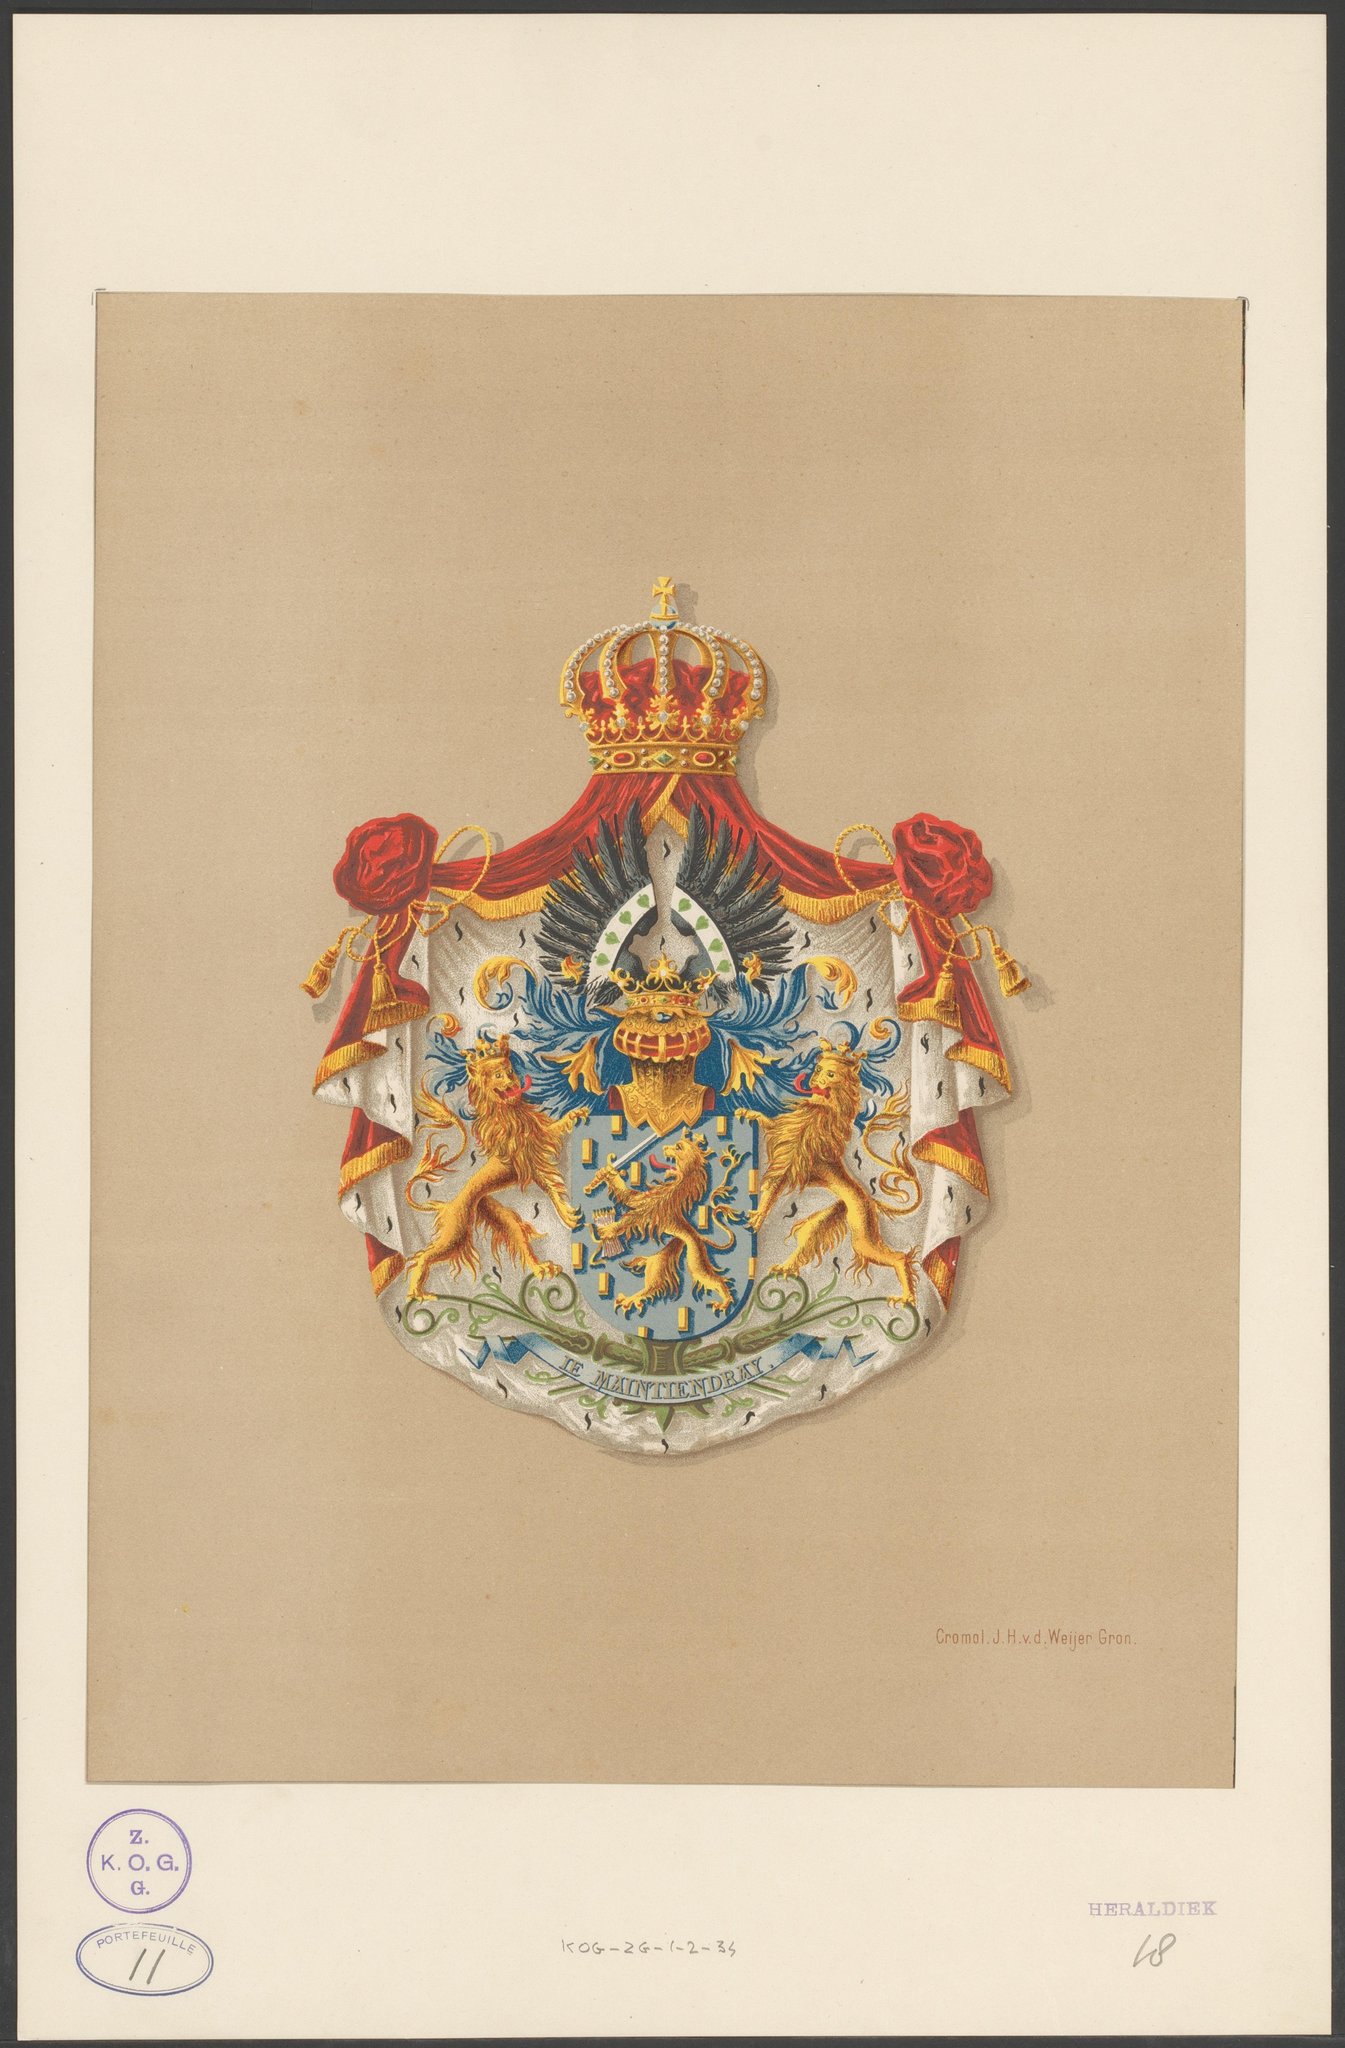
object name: print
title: 's Konings Wapen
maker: johannes hermanus van de weijer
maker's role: print maker, printer, publisher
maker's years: 1817-1889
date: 1840-1876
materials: paper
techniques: chromolithography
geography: groningen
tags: armorial bearing, heraldry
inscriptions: collector's mark, collector's mark: Lugt 1641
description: Wapen van de koning van het Koninkrijk der Nederlanden (mogelijk ontwerp). Wapendier en schilderhouders nu zonder rangkronen. Met motto, gouden helm met pauwevlucht als helmteken. Met mantel en kroon. Onderwerpsrubrieken binnen de Atlas Zeden en Gewoonten: Regeering, Wapens (Heraldiek), Wapens van Regeerende Huizen.